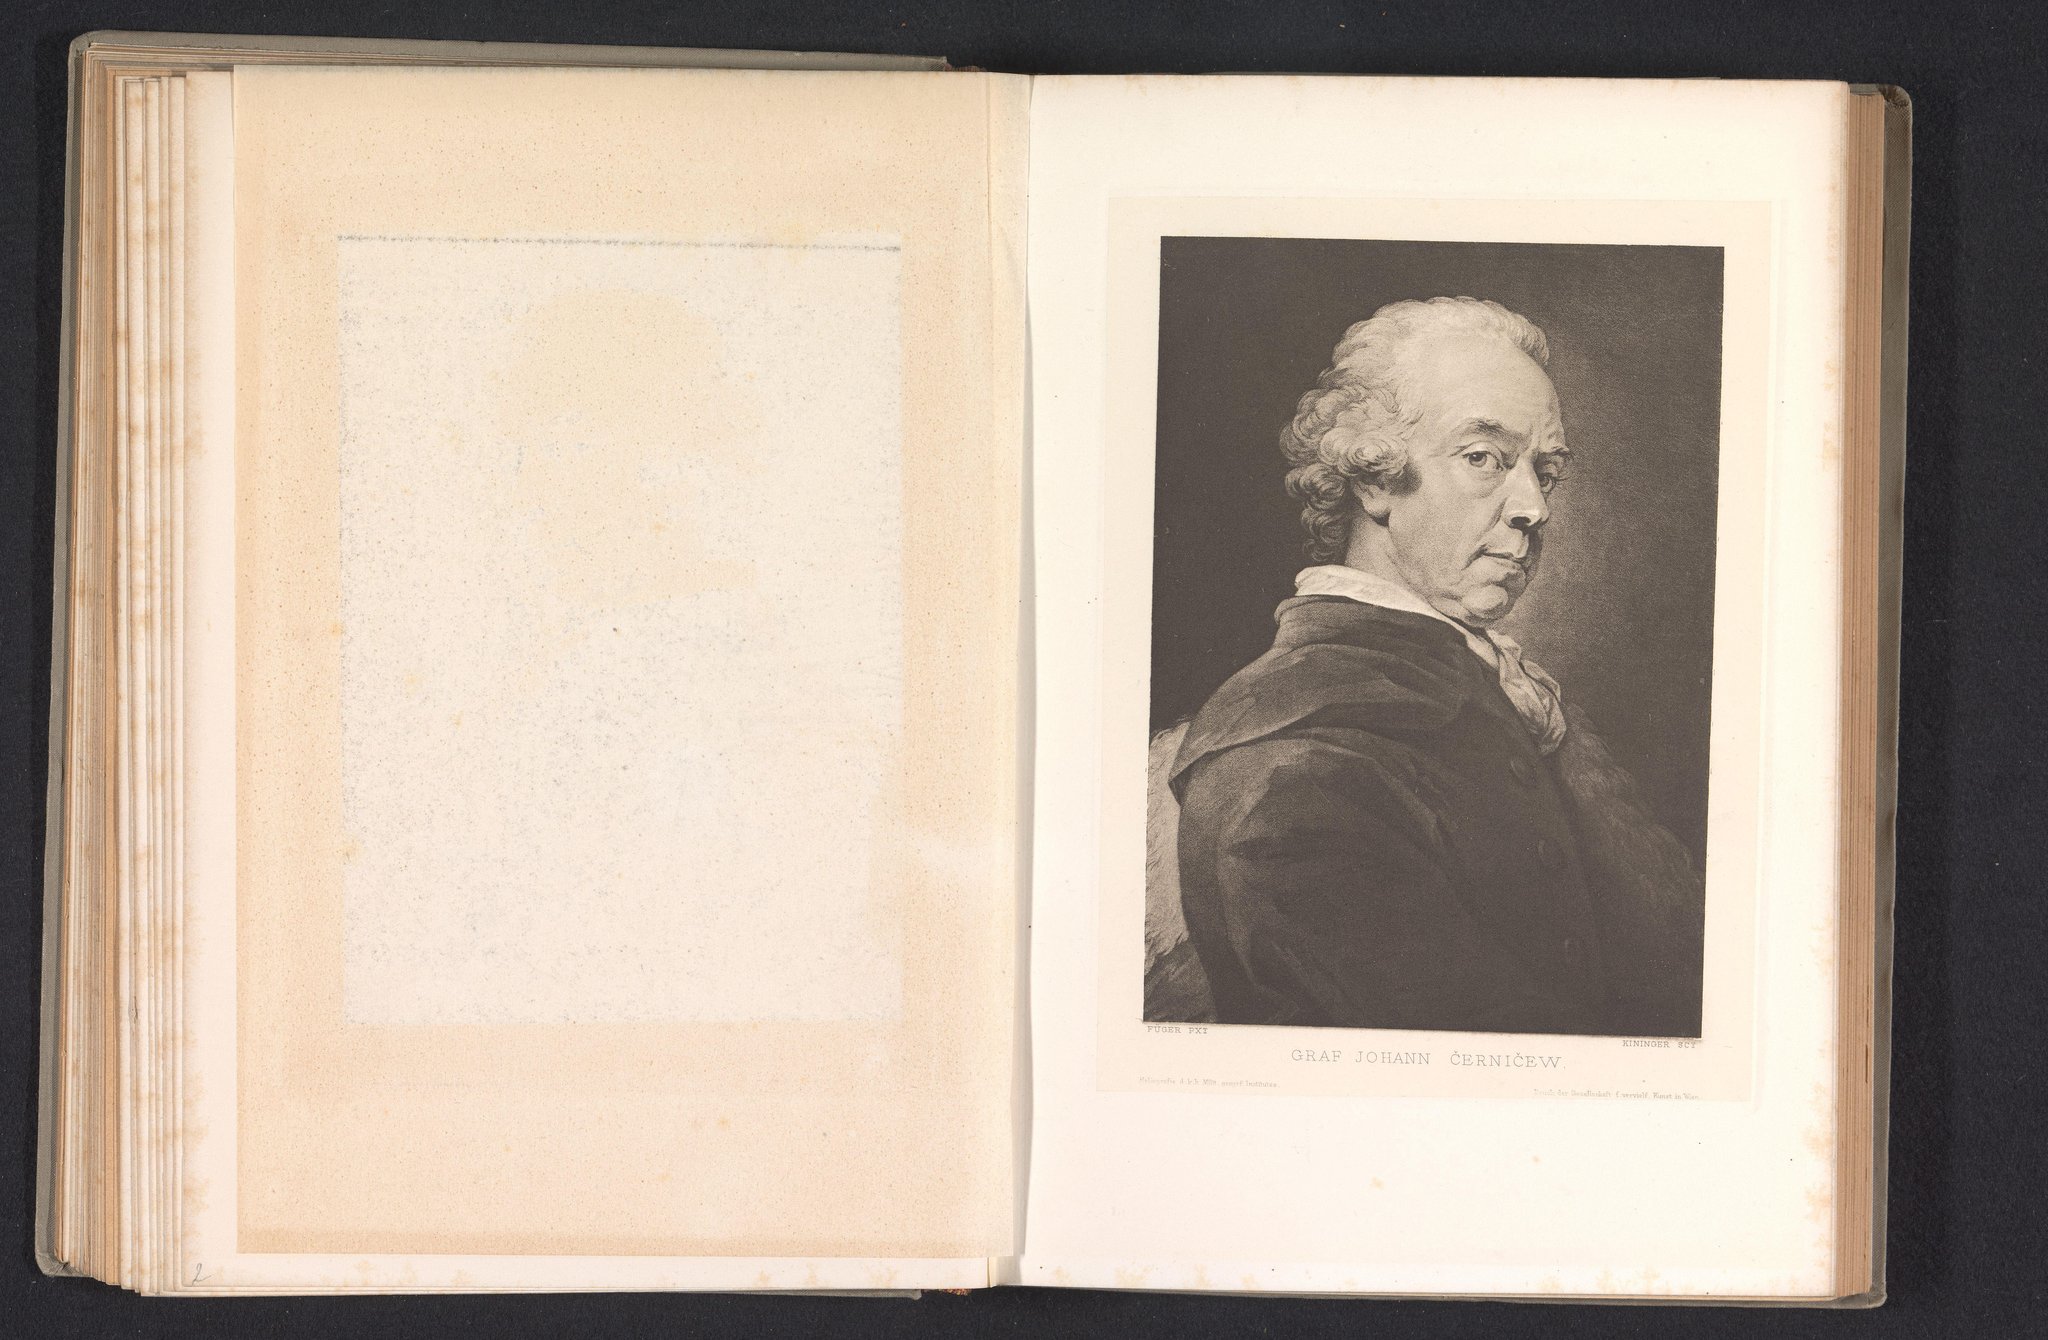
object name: photomechanical print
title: Graf Johann Černičew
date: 1878-1883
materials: paper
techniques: photoaquatint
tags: adult man